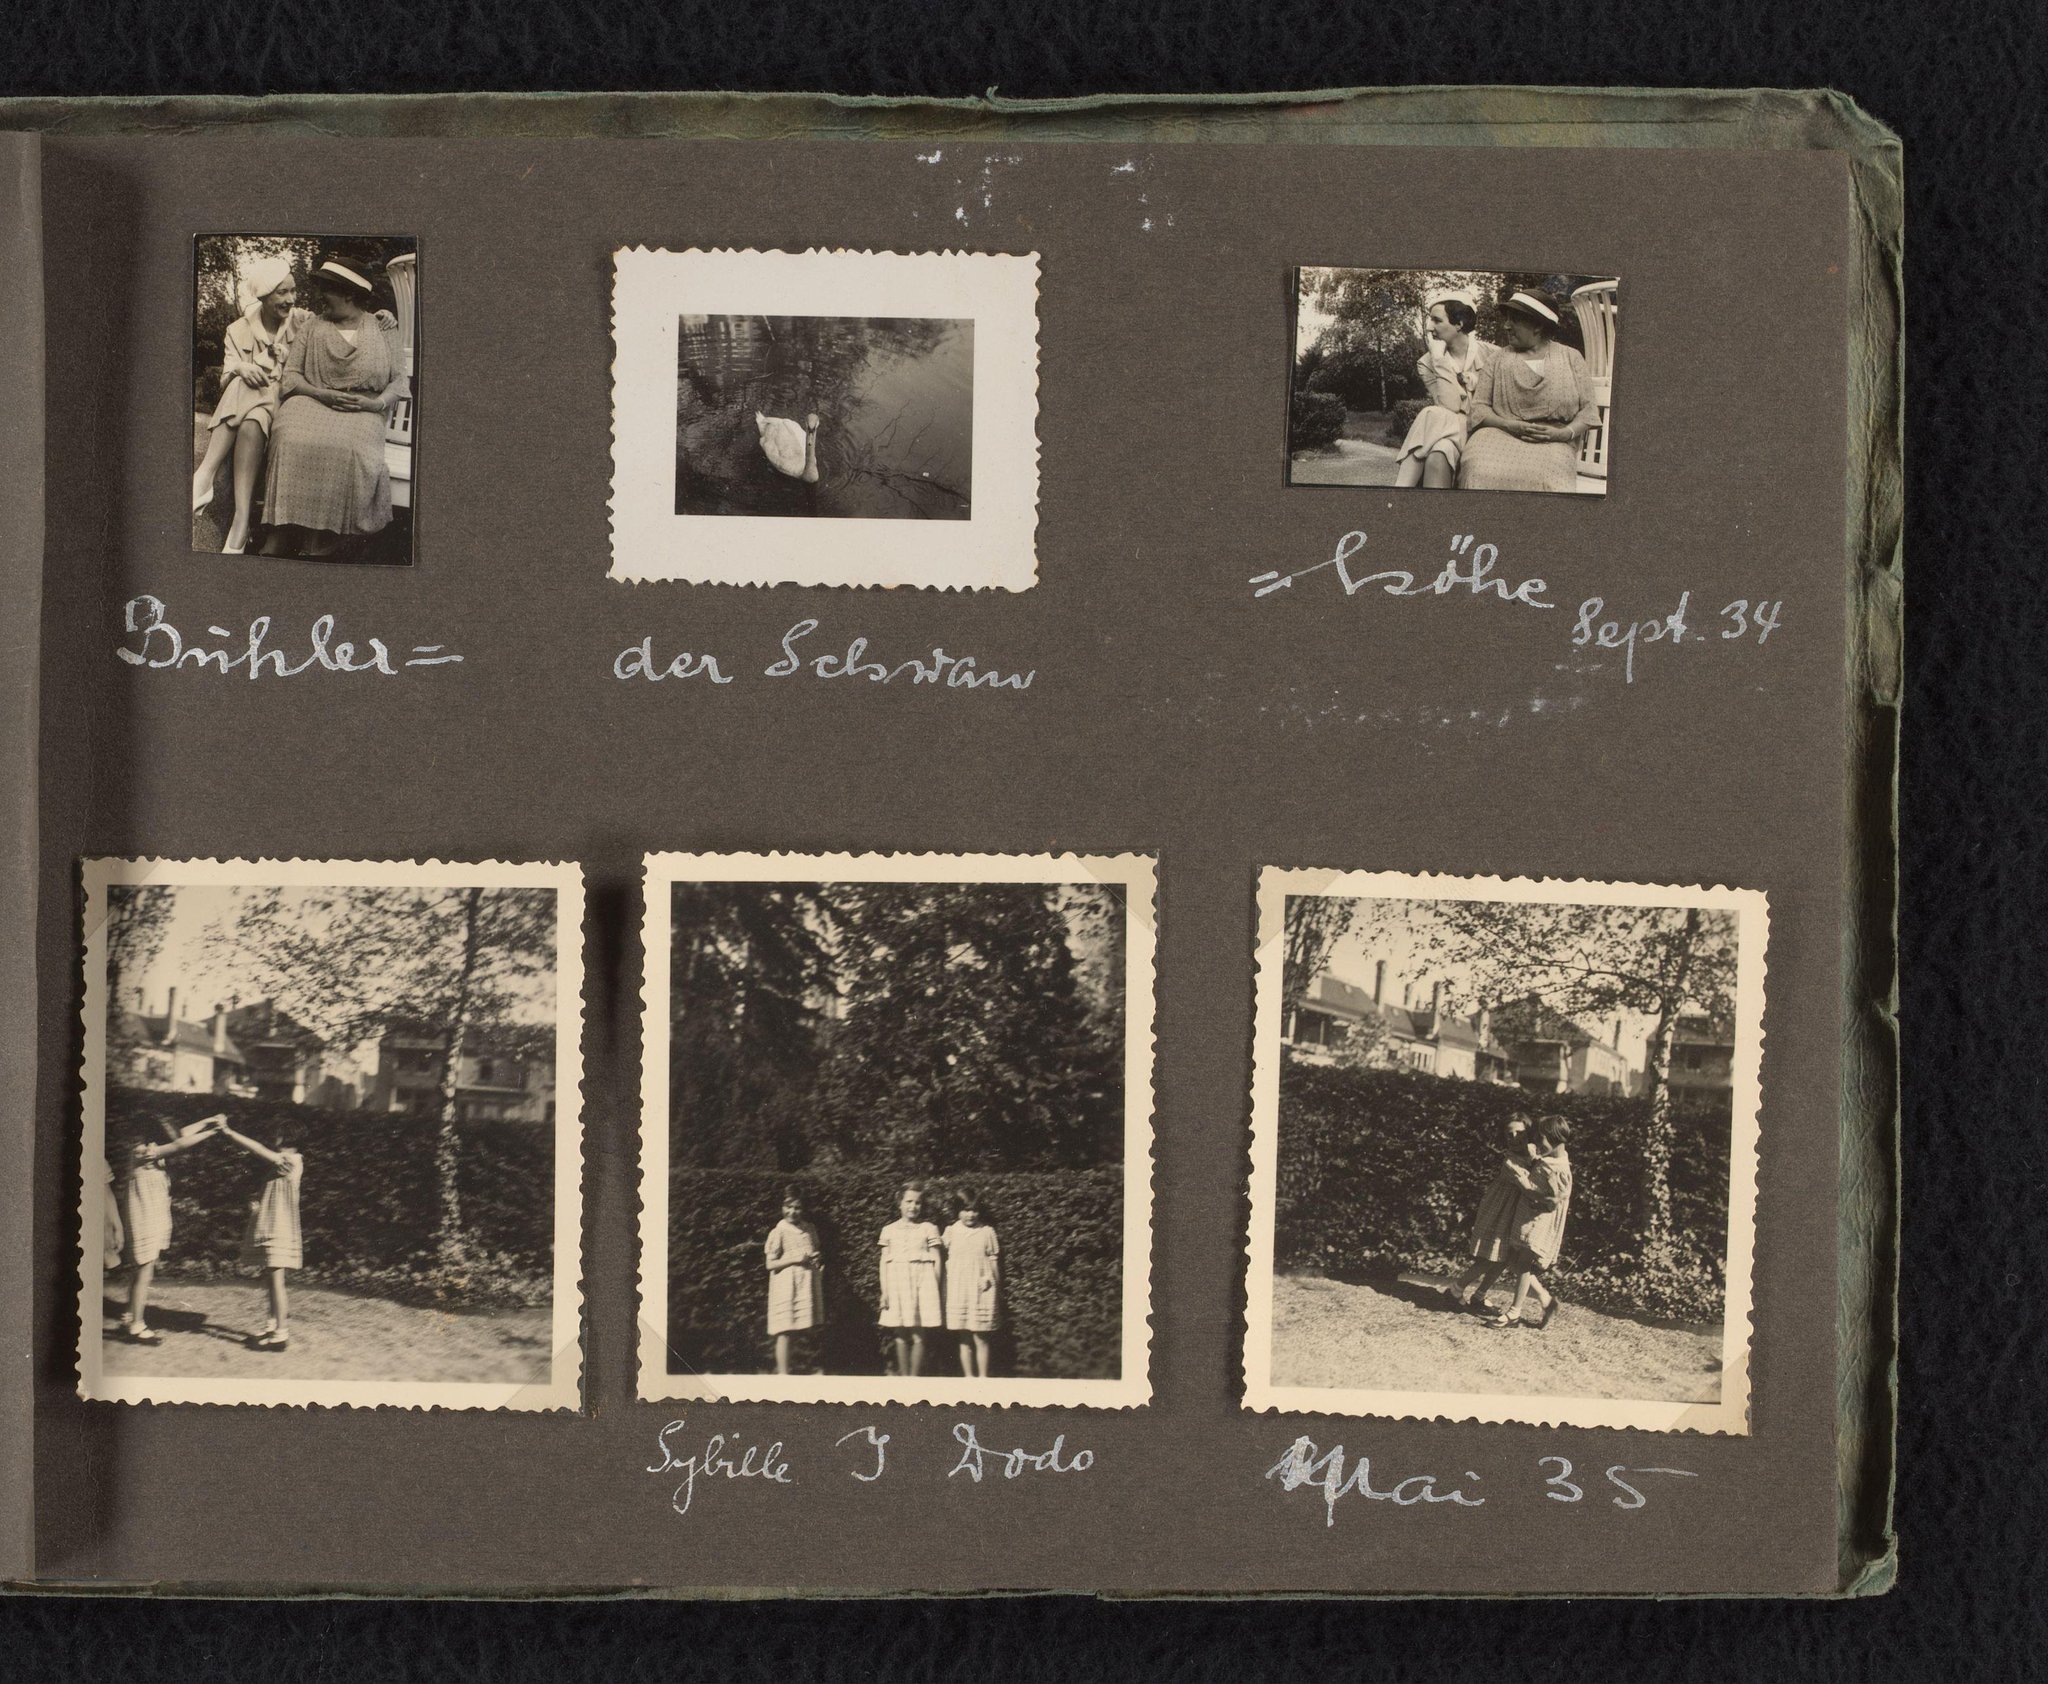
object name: photograph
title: Isabel Wachenheimer met vriendinnetjes in de tuin, en Else Wachenheimer met onbekende vrouw in de tuin, september 1934-mei 1935, Duitsland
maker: else wachenheimer-moos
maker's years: 1895-1944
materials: paper, photographic support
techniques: gelatin silver print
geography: germany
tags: else wachenheimer-moos, leiden, isabel wachenheimer-elon, family life at home, germany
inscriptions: inscription: ‘Bühler= der Schwan= höhe Sept.34 Sybille u Dodo Mai 35’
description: Blad bevat zes foto's. Alle foto's van Else Wachenheimer-Moos (in lichte kleding), onbekende vrouw (in witte kleding), Isabel Wachenheimer (met blond haar) en twee onbekende meisjes (met donker haar). Uit het album, half formaat, groen geaderd kartonomslag met koordbinding.